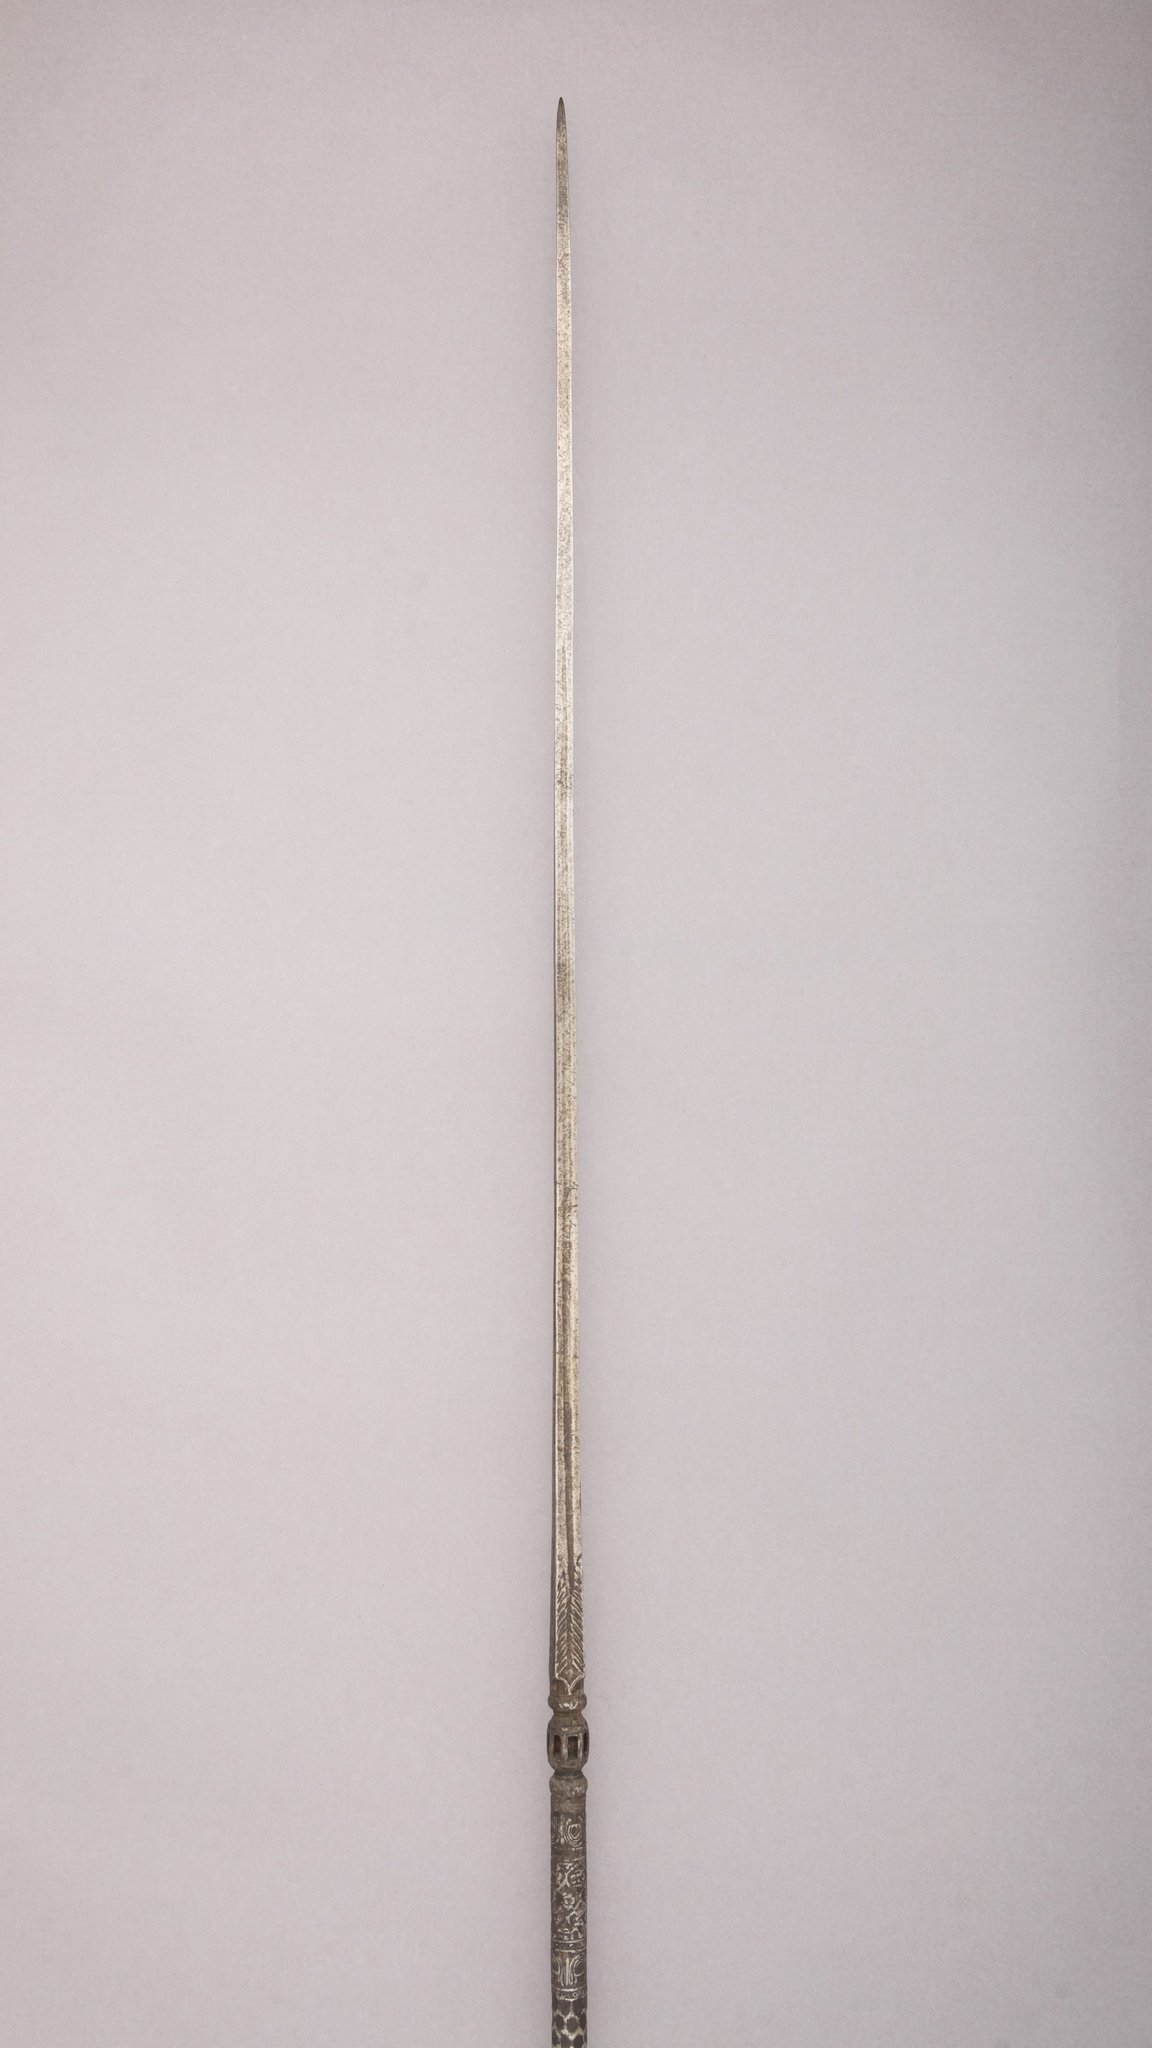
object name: spear sang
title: Spear (Sang)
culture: indian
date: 1701-1900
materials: iron, silver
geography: india